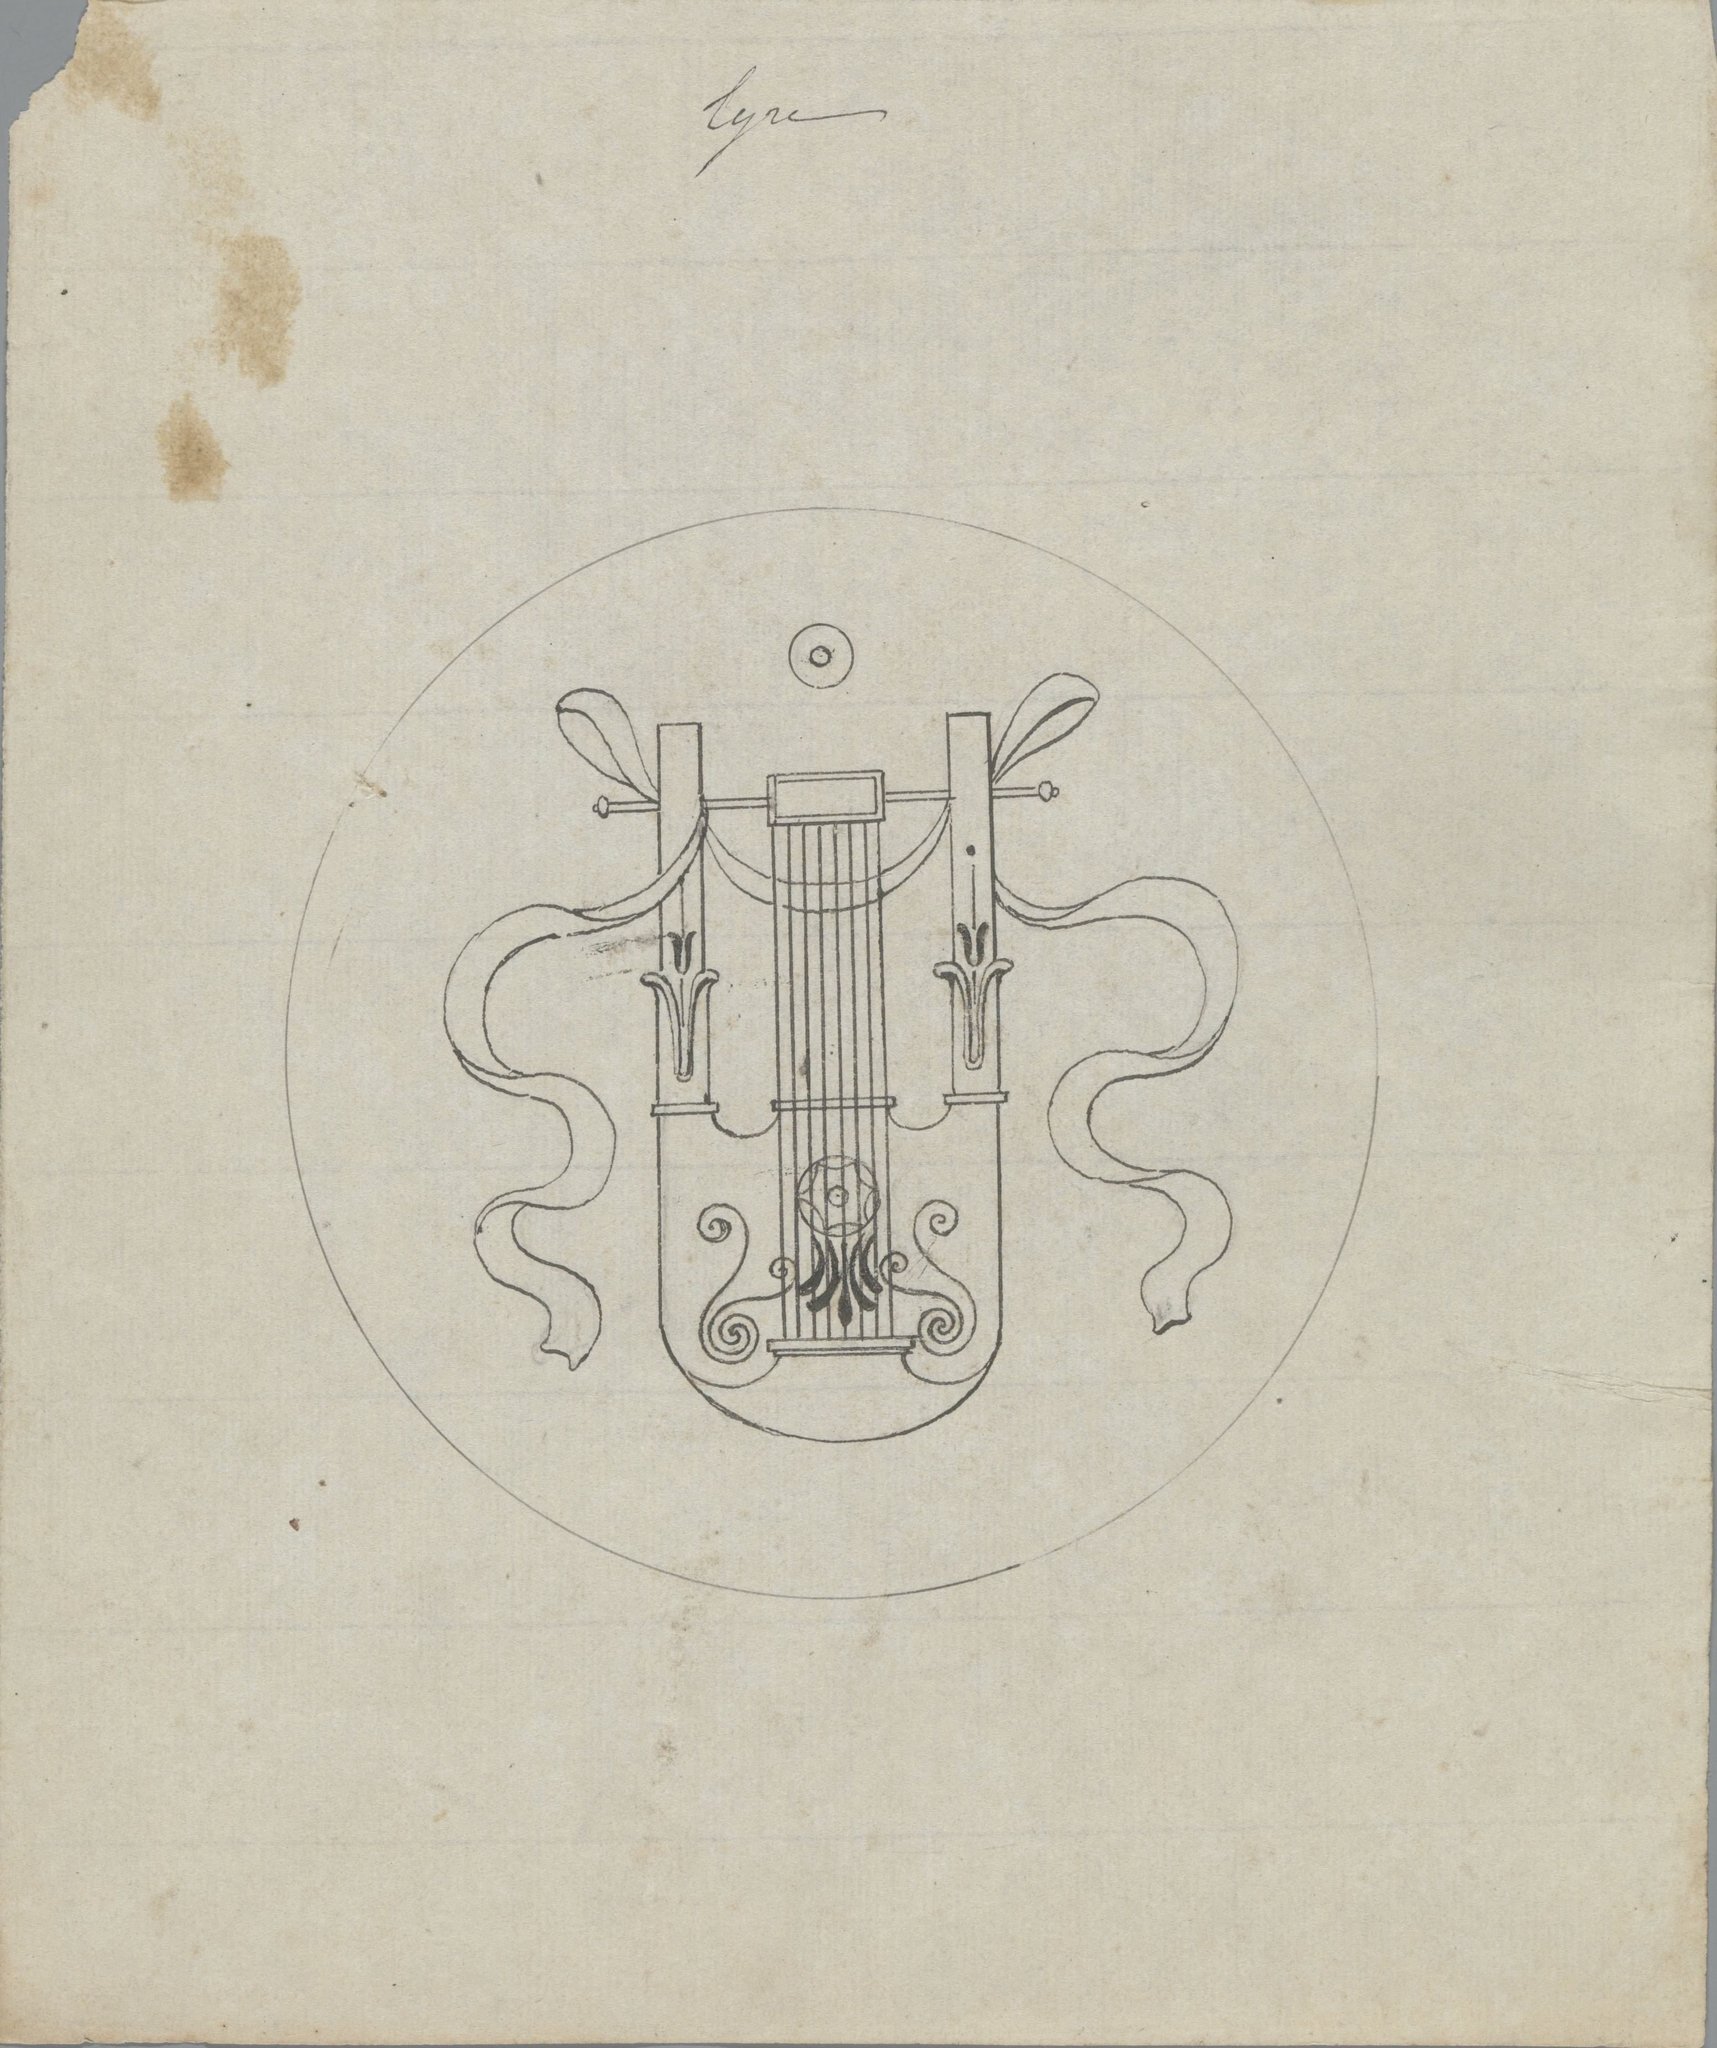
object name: design drawing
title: Ontwerp voor marqueterie van aan linten opgehangen muziekinstrument(en) in rond medaillon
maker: pierre félix van doren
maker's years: 1797-1856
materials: graphite, ink, paper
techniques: pen in black ink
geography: brussels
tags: trophy, i.e.: decorative arrangement of symbolic or typical objects ~ ornament, lyre, cithara, psaltery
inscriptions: inscription: ‘lyre’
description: Een van 103 ontwerpen voor marqueterie van aan linten opgehangen muziekinstrumenten in ronde medaillons, bestemd voor de set stoelen gemaakt door Van Doren voor de grote zaal van het Paleis van de Prins van Oranje in Brussel in 1828.